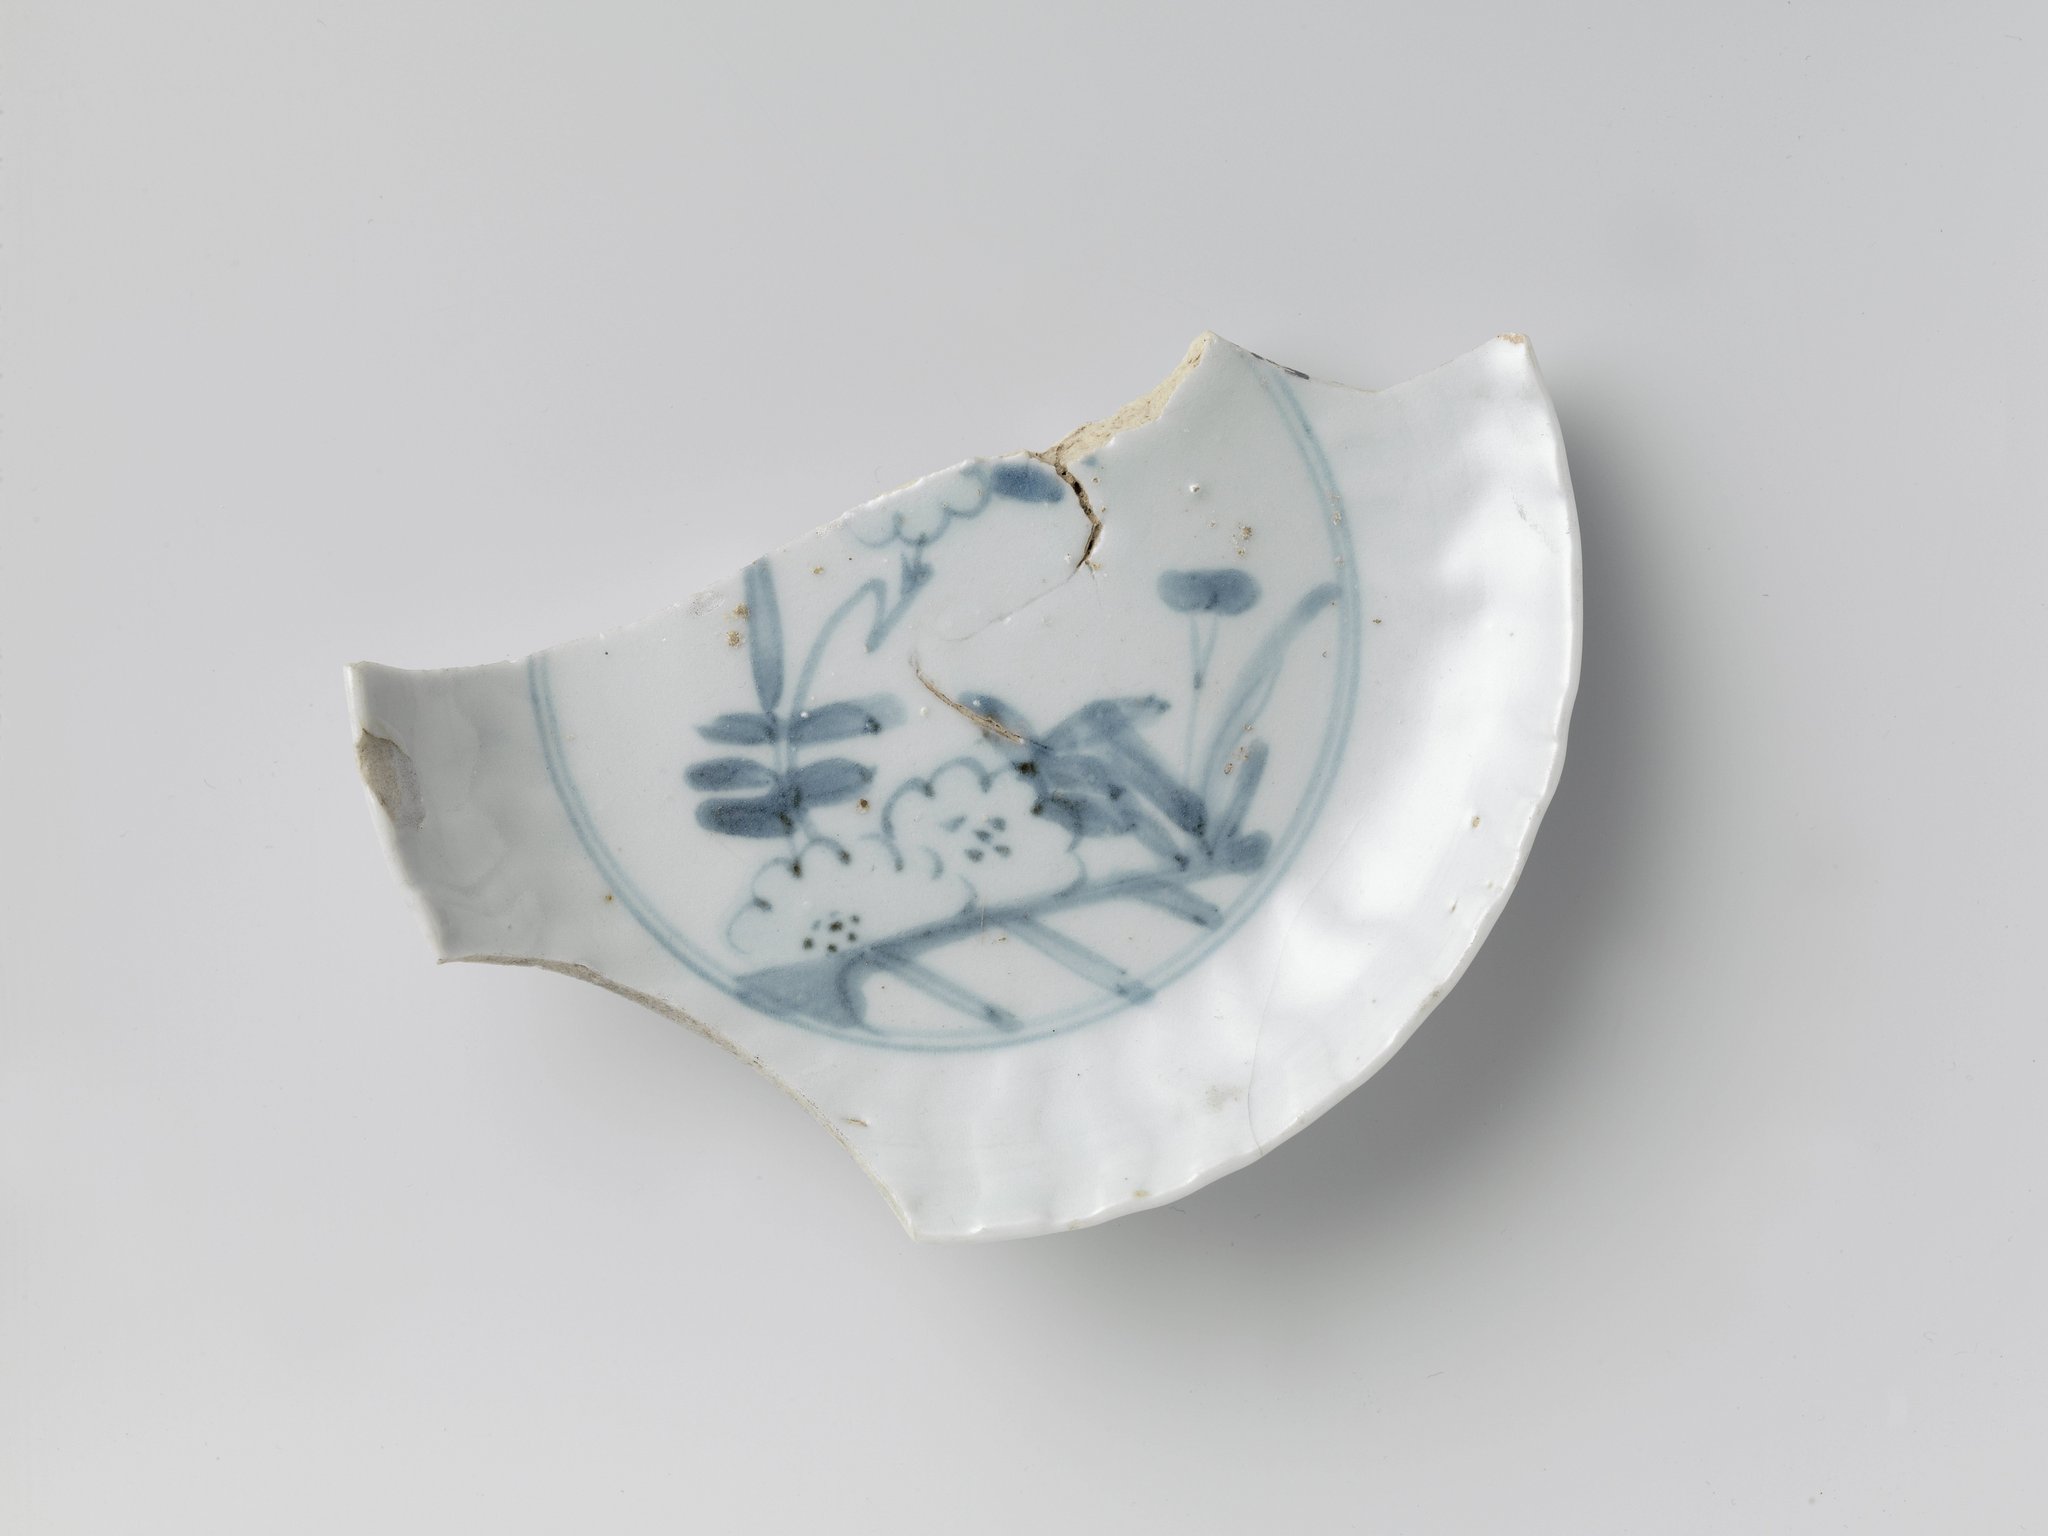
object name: platter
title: Scherd of a saucer with flower sprays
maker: Anonymous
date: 1600-1624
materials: cobalt, glaze, paint, porcelain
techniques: firing, turning, vitrification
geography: japan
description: Scherf van een schotel van porselein met geribde wand, beschilderd in onderglazuur blauw. Op het plat een medaillon met bloemtakken achter een hekje. Blauw-wit.